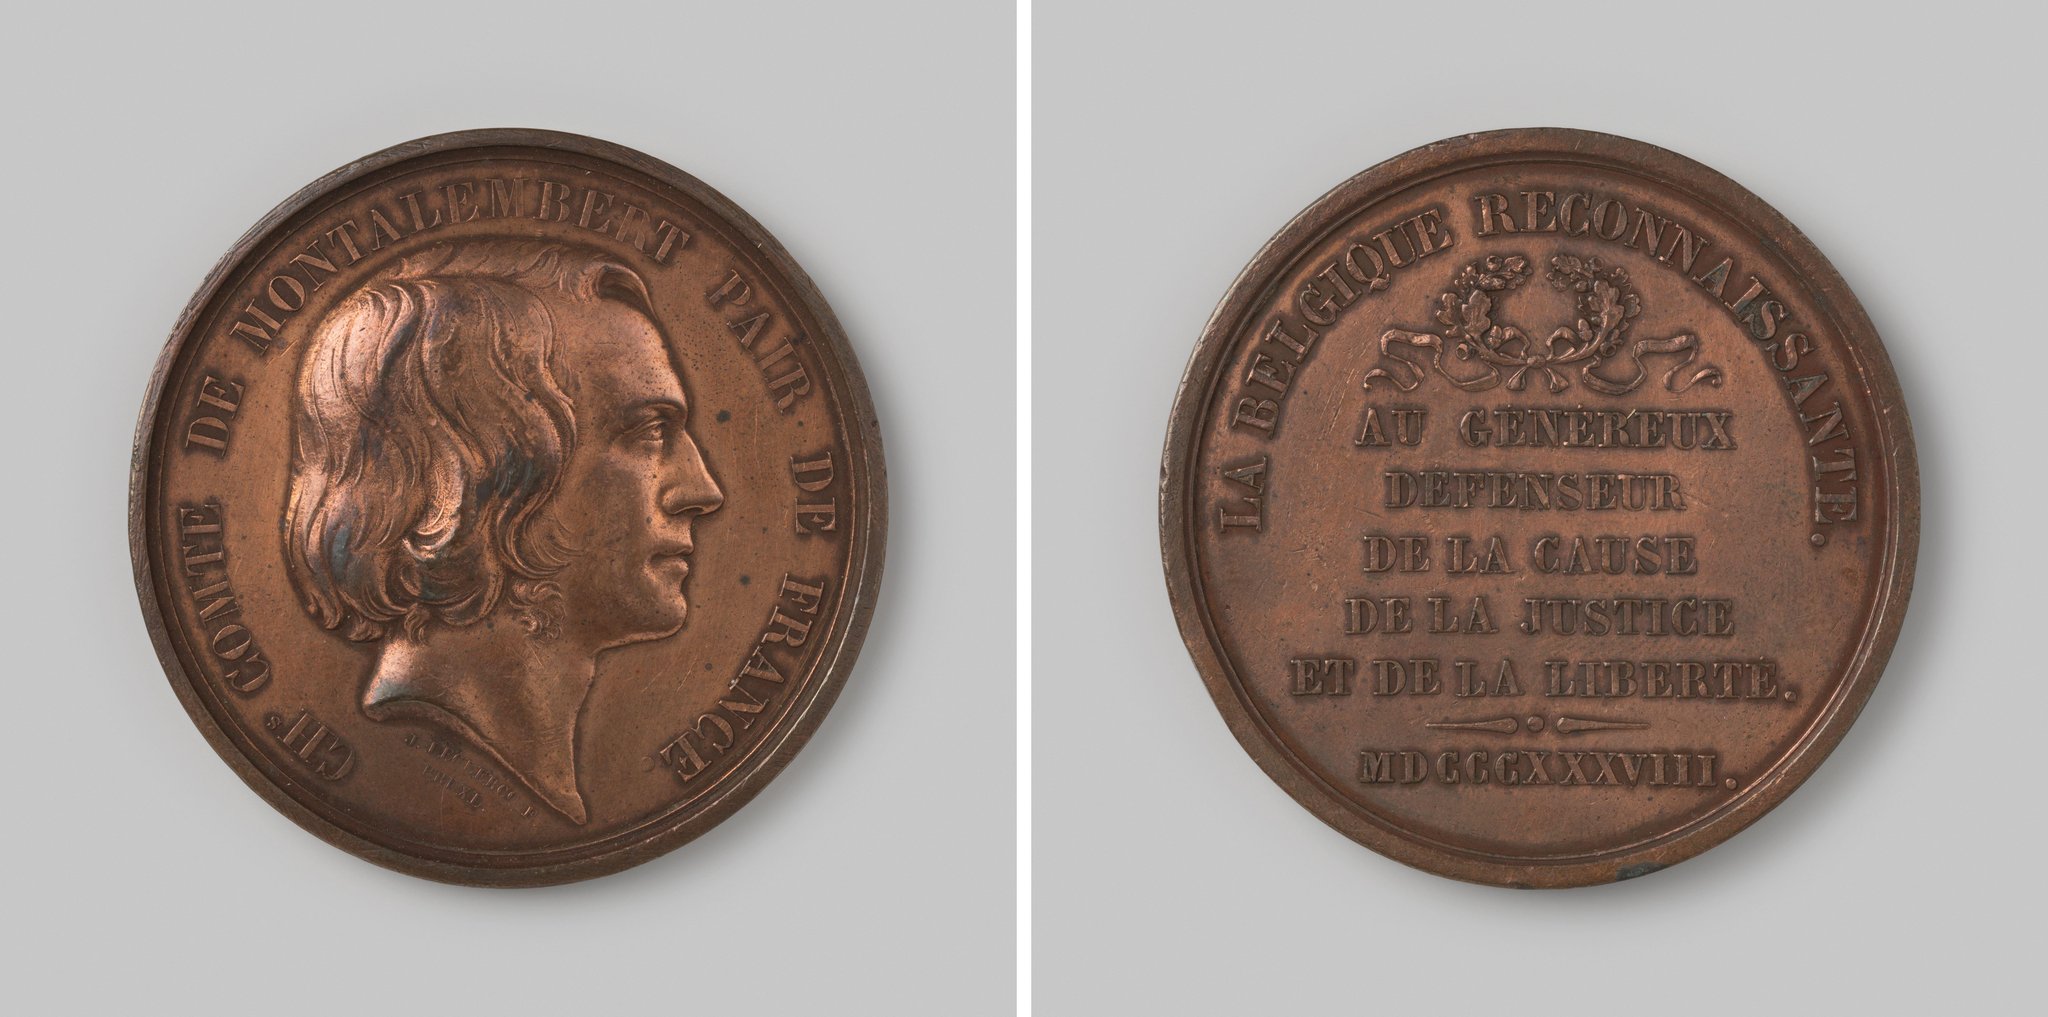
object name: history medal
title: Bemiddeling van Graaf De Montalembert tussen België en Frankrijk 1838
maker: julien gabriel leclercq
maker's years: 1805-1882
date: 1838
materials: copper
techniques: striking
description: Bronzen penning, op de voorzijde het portret van De Montalembert naar rechts met omschrift, op de keerzijde onder een lauwerkrans zes regels tekst, met bovenaan omschrift.